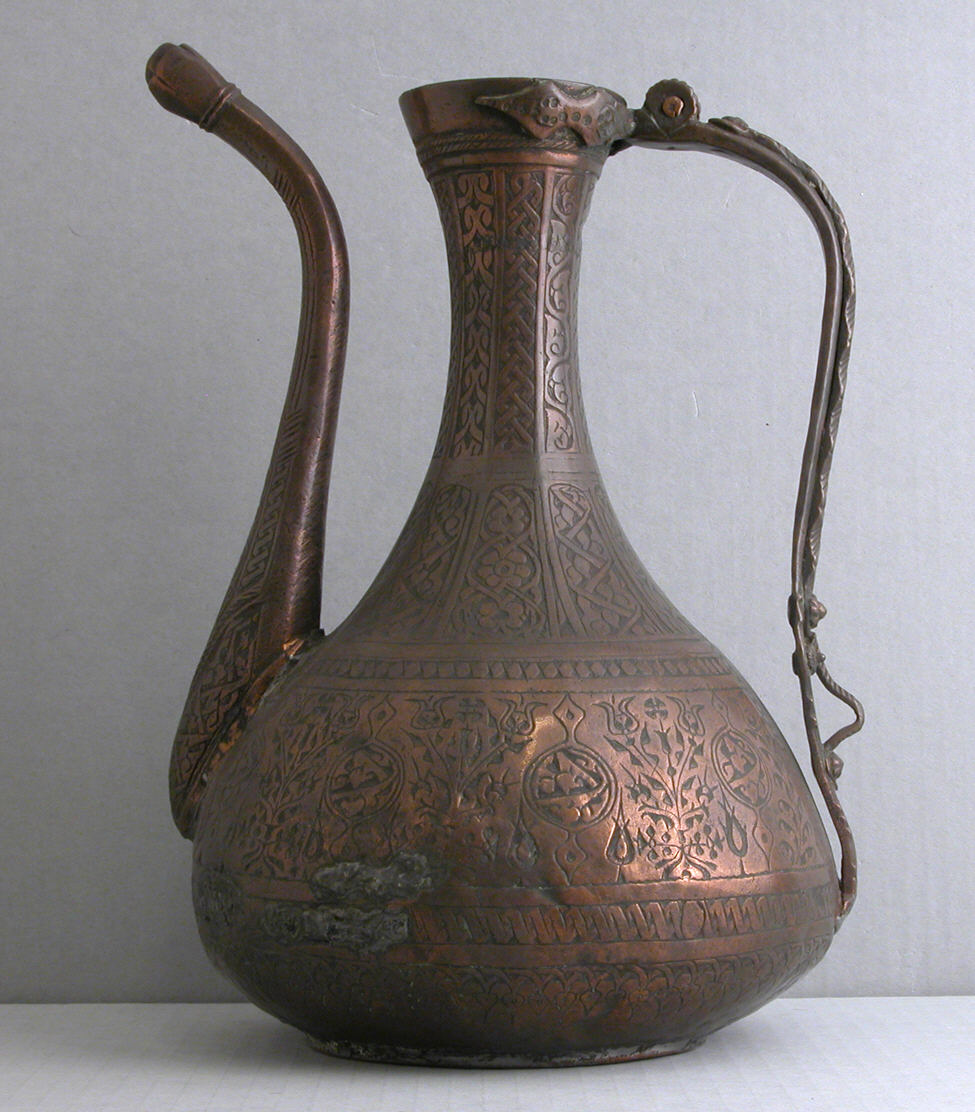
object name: ewer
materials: copper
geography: turkey